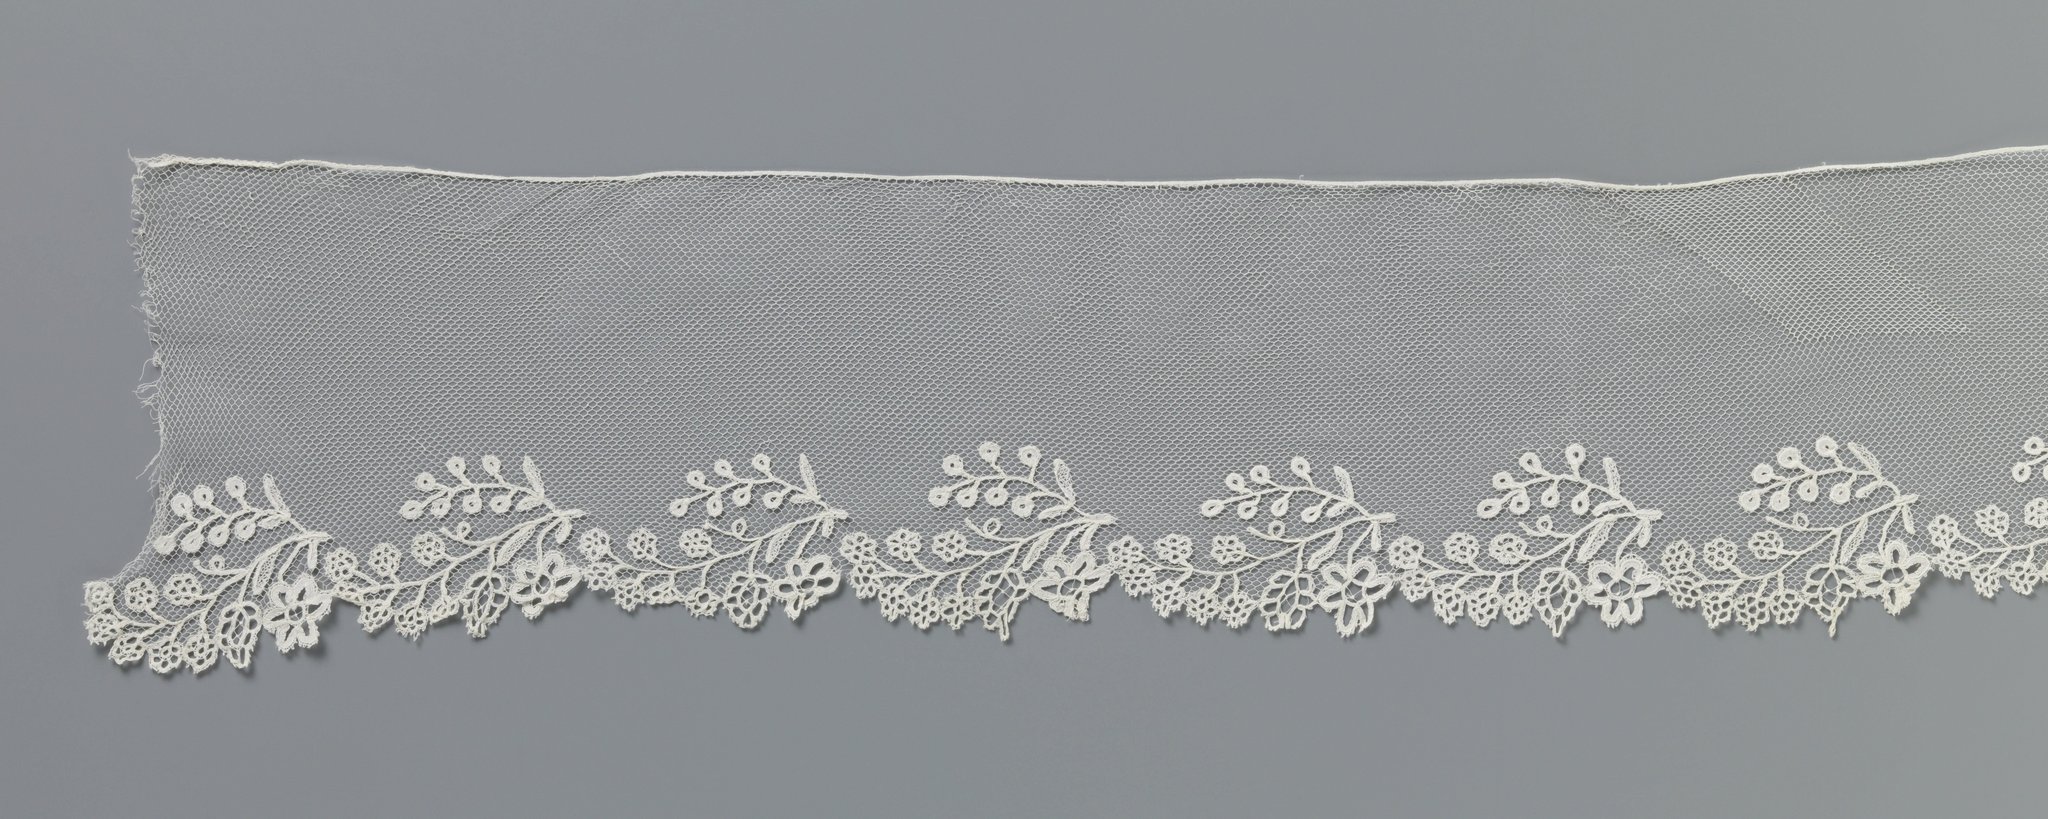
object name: strip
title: Strook applicatiekant met bloesemtakjes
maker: Anonymous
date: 1890-1909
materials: linen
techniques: lace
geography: brussels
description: Strook naturelkleurige applicatiekant, kloskant geappliceerd op machinale tule. Driekwart van het fond is onversierd. Een open rand bestaat uit liggende bloesemtakjes, die naar links gewend zijn. Enige bloesems en een 'roosje' vormen de schulpjes.